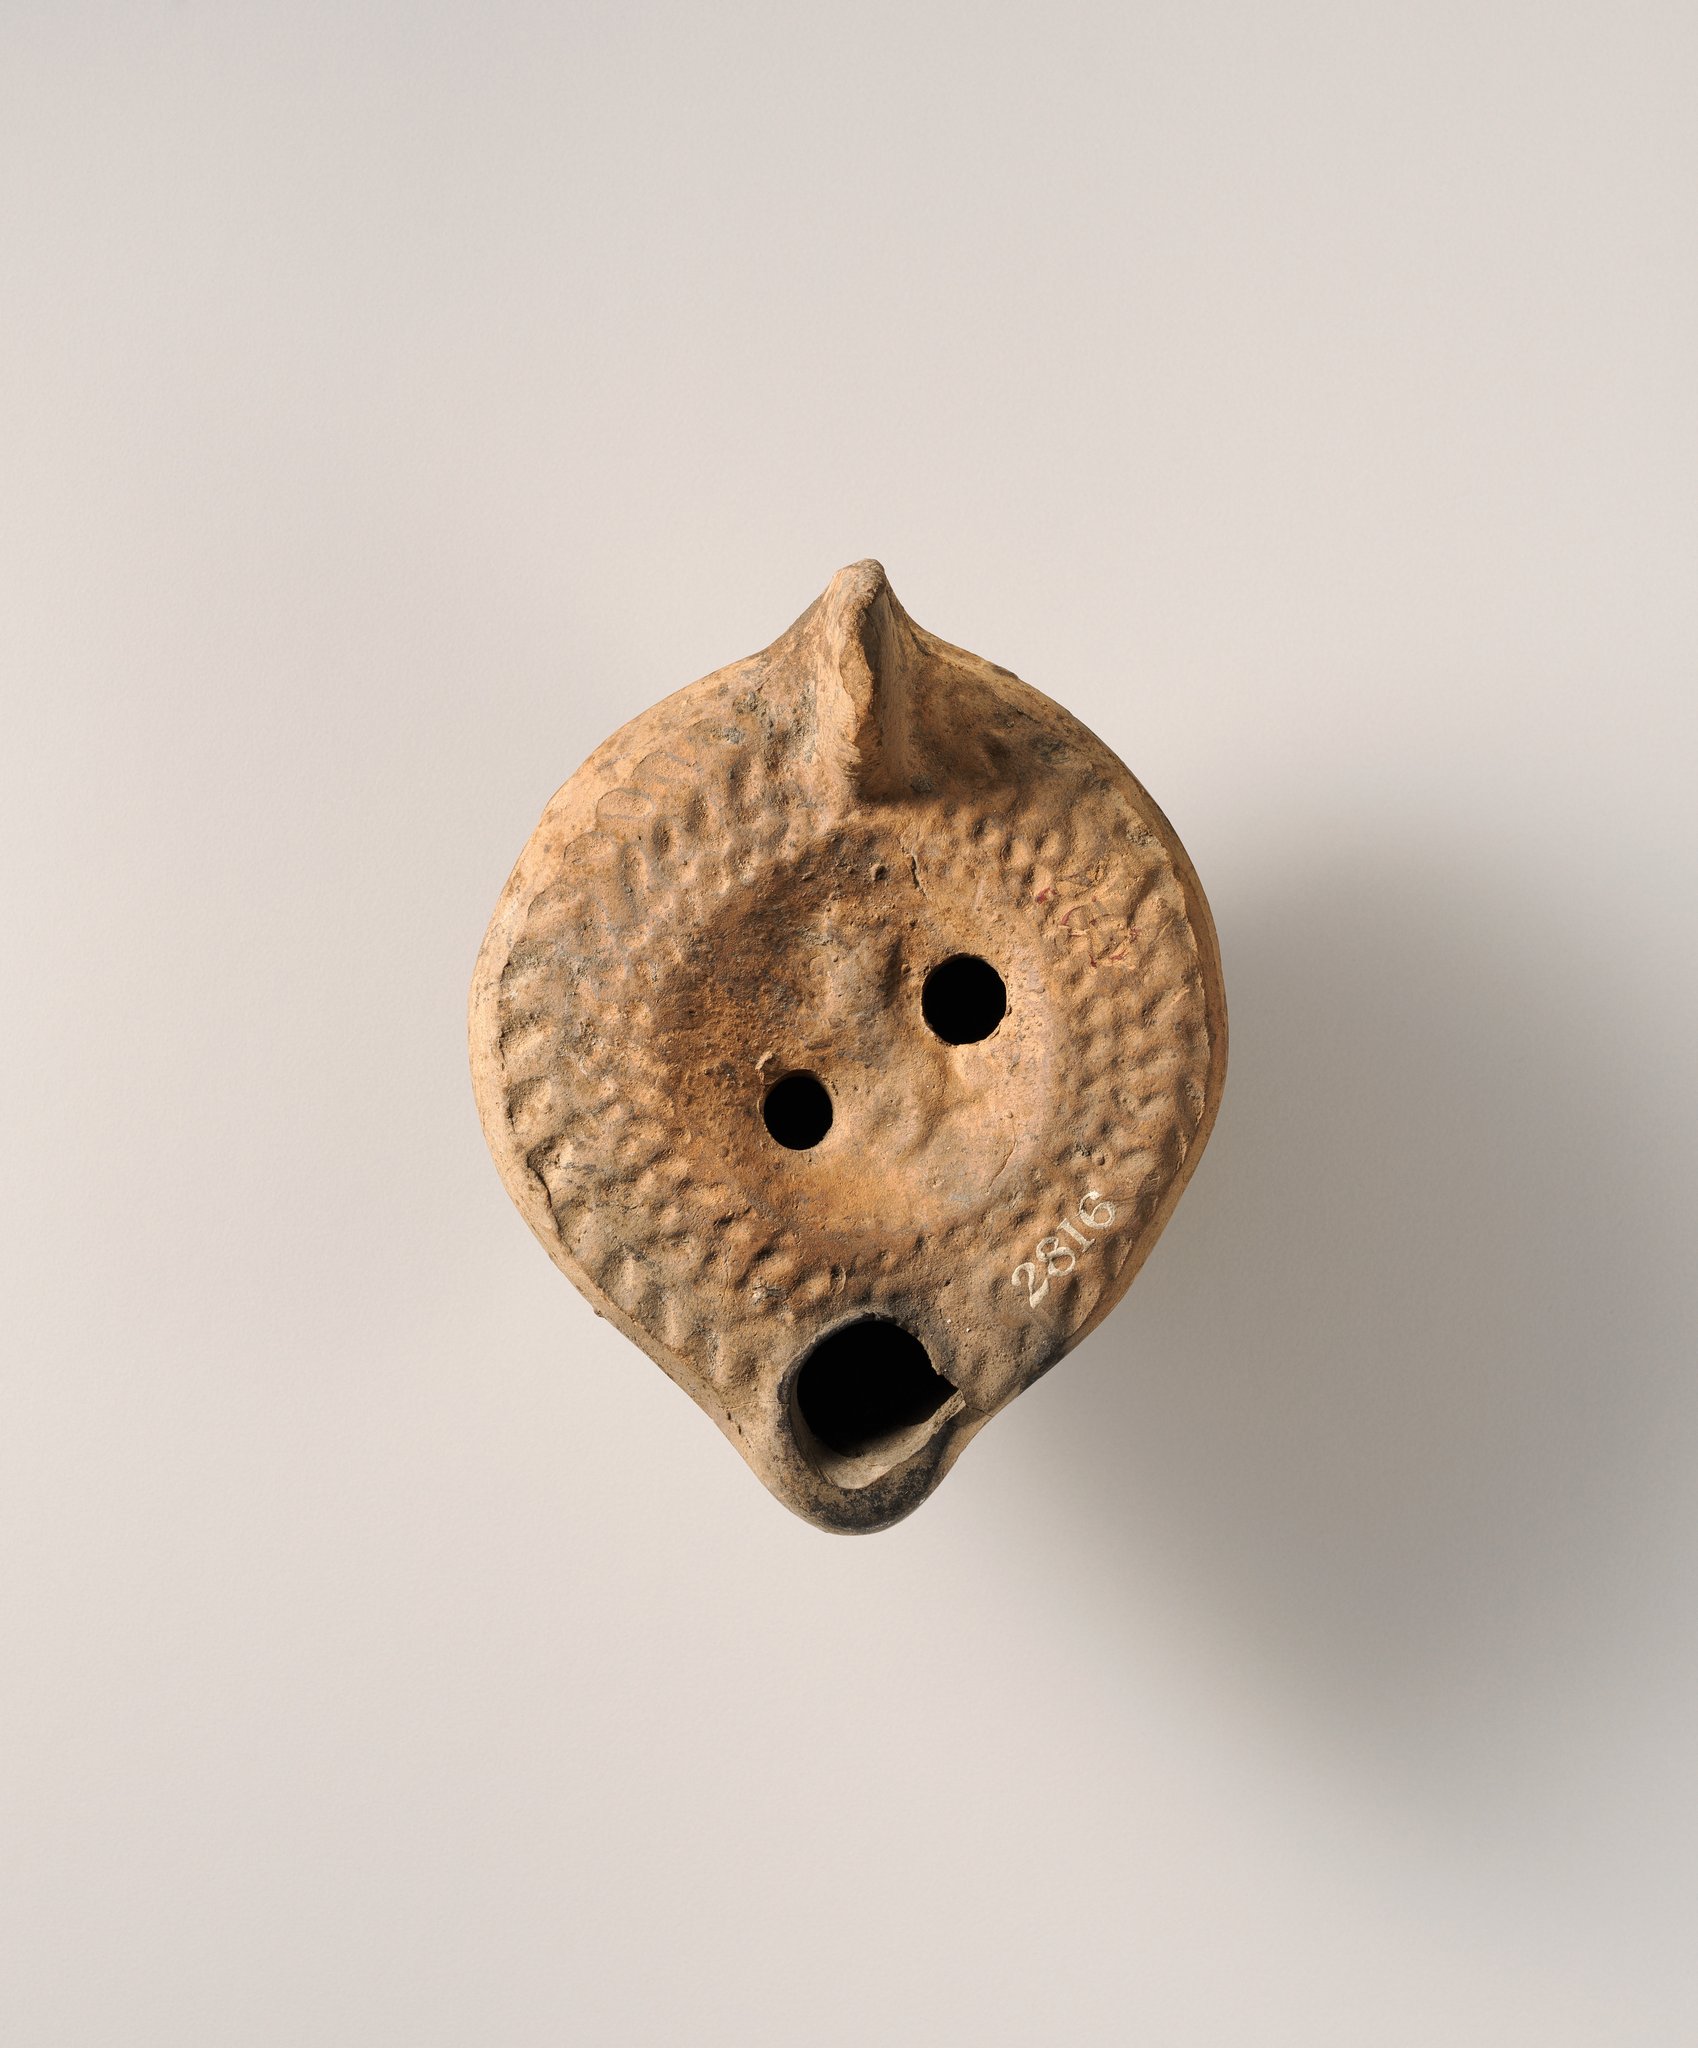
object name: lamp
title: Terracotta oil lamp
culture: roman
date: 201-366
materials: terracotta